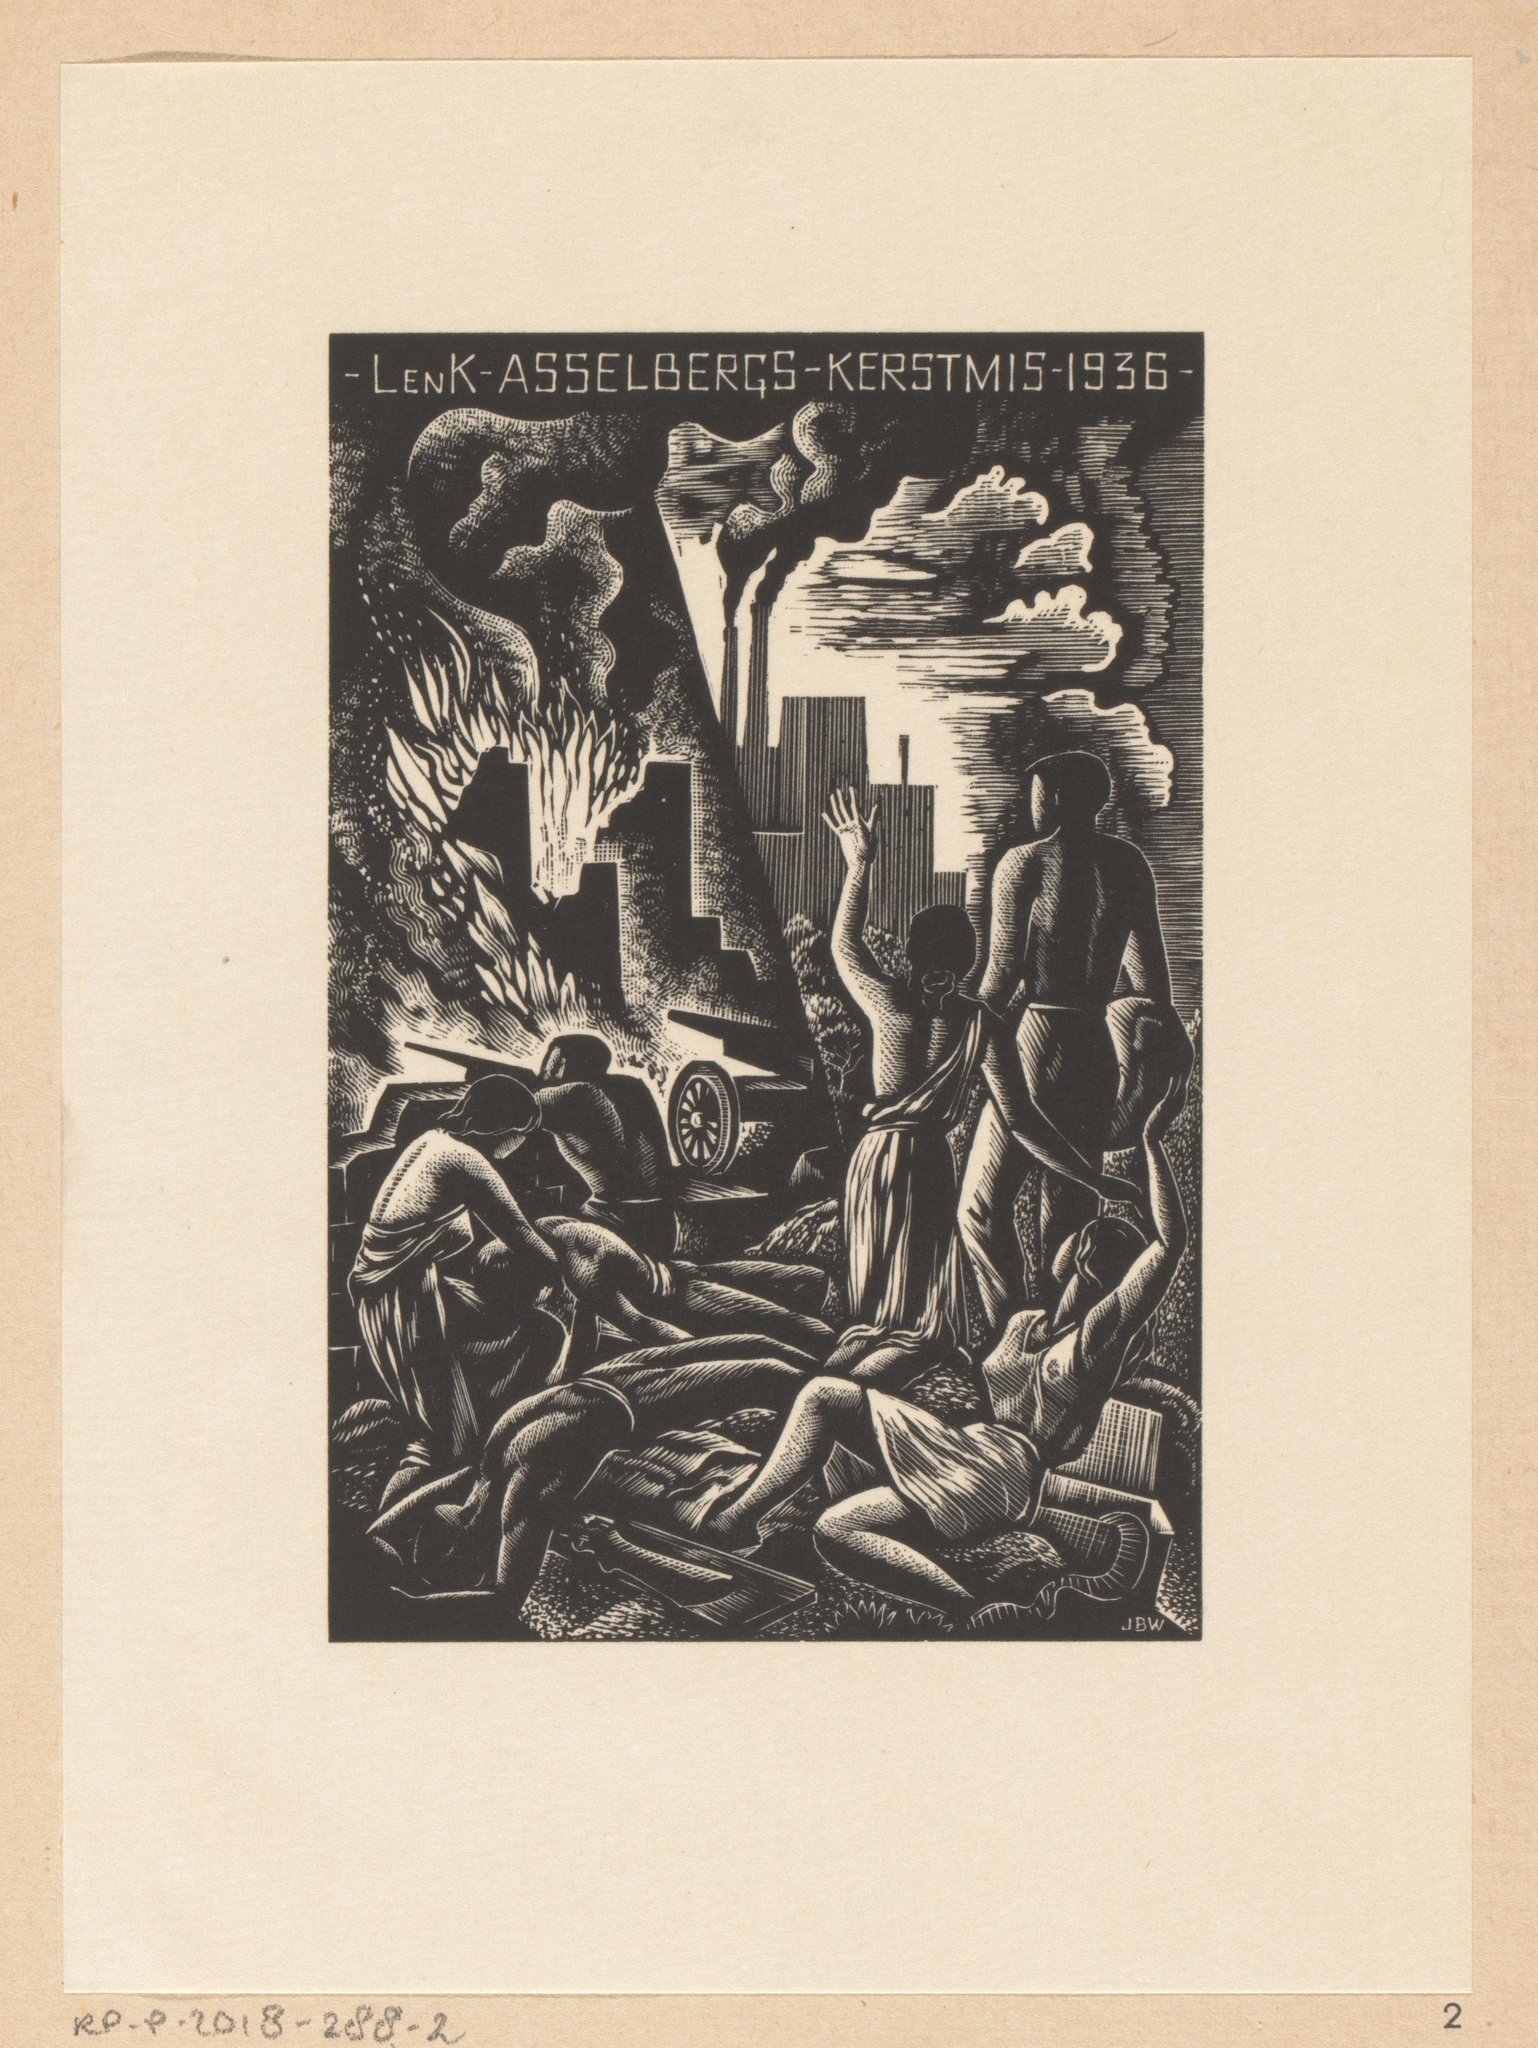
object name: christmas card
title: Kerstkaart van L. en K. Asselbergs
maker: john buckland wright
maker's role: print maker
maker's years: 1897-1954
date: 1936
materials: paper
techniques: engraving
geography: england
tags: factory-building, warfare; military affairs, firearms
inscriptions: date